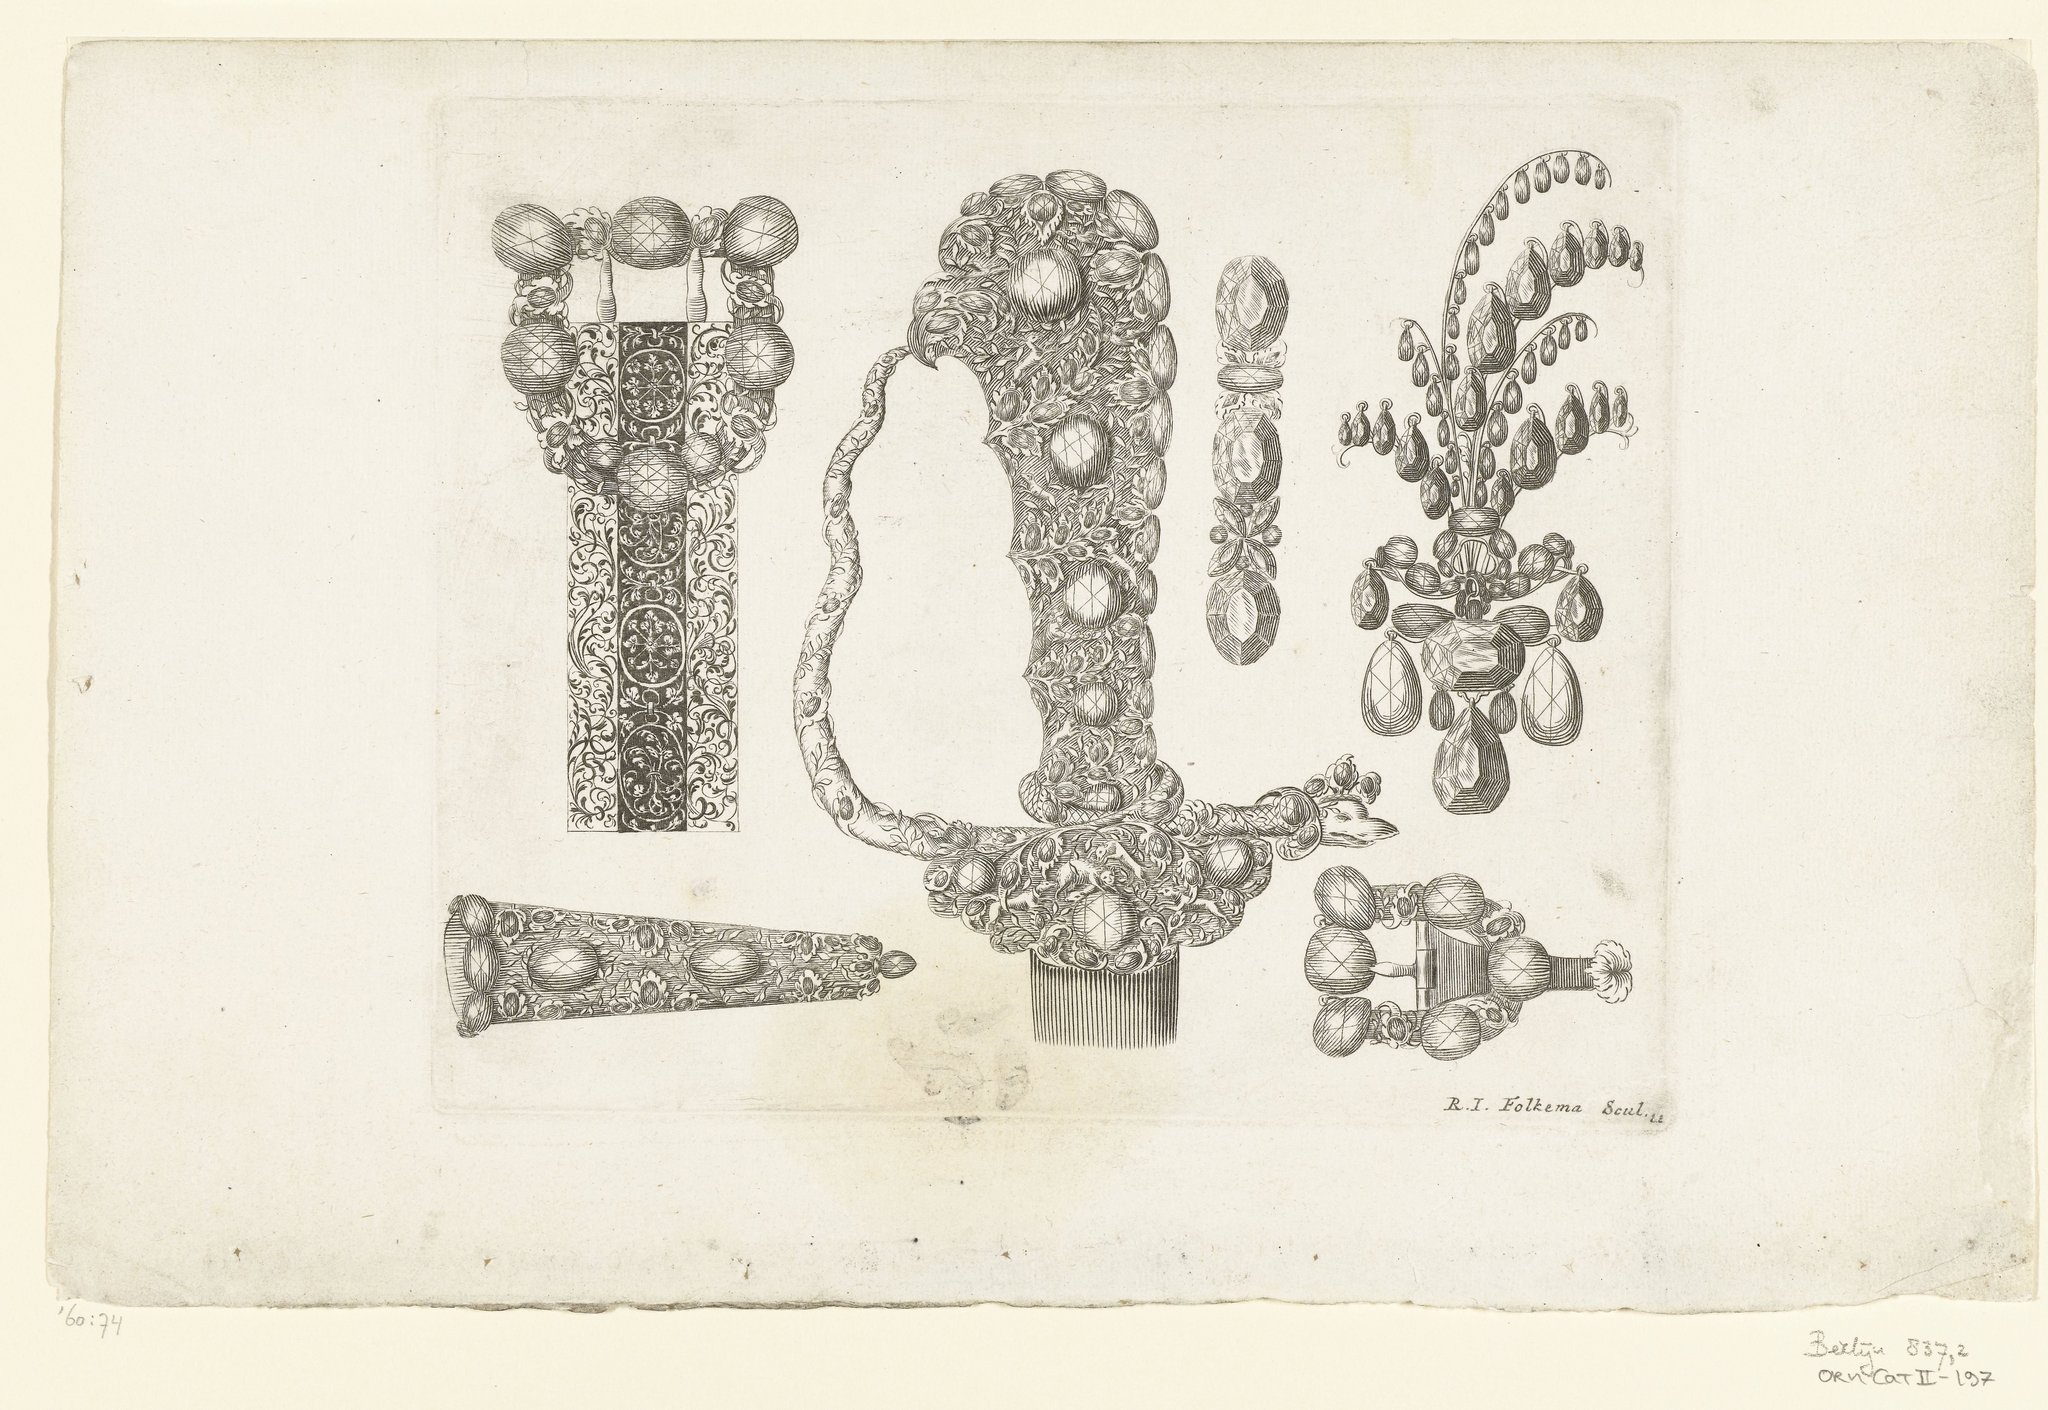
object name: print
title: Zes motieven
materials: paper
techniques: engraving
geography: amsterdam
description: In het midden een zwaardgevest bezet met edelstenen en geheel rechts een aigrette. Blad 11 uit serie met bladranken en ontwerpen voor edelsmeden, Nederlandse kopieën van ontwerpen door Thomas Lejuge, Jean Louis Durant en Friedrich Jacob Morisson. Tweede editie, tweede afdruk.